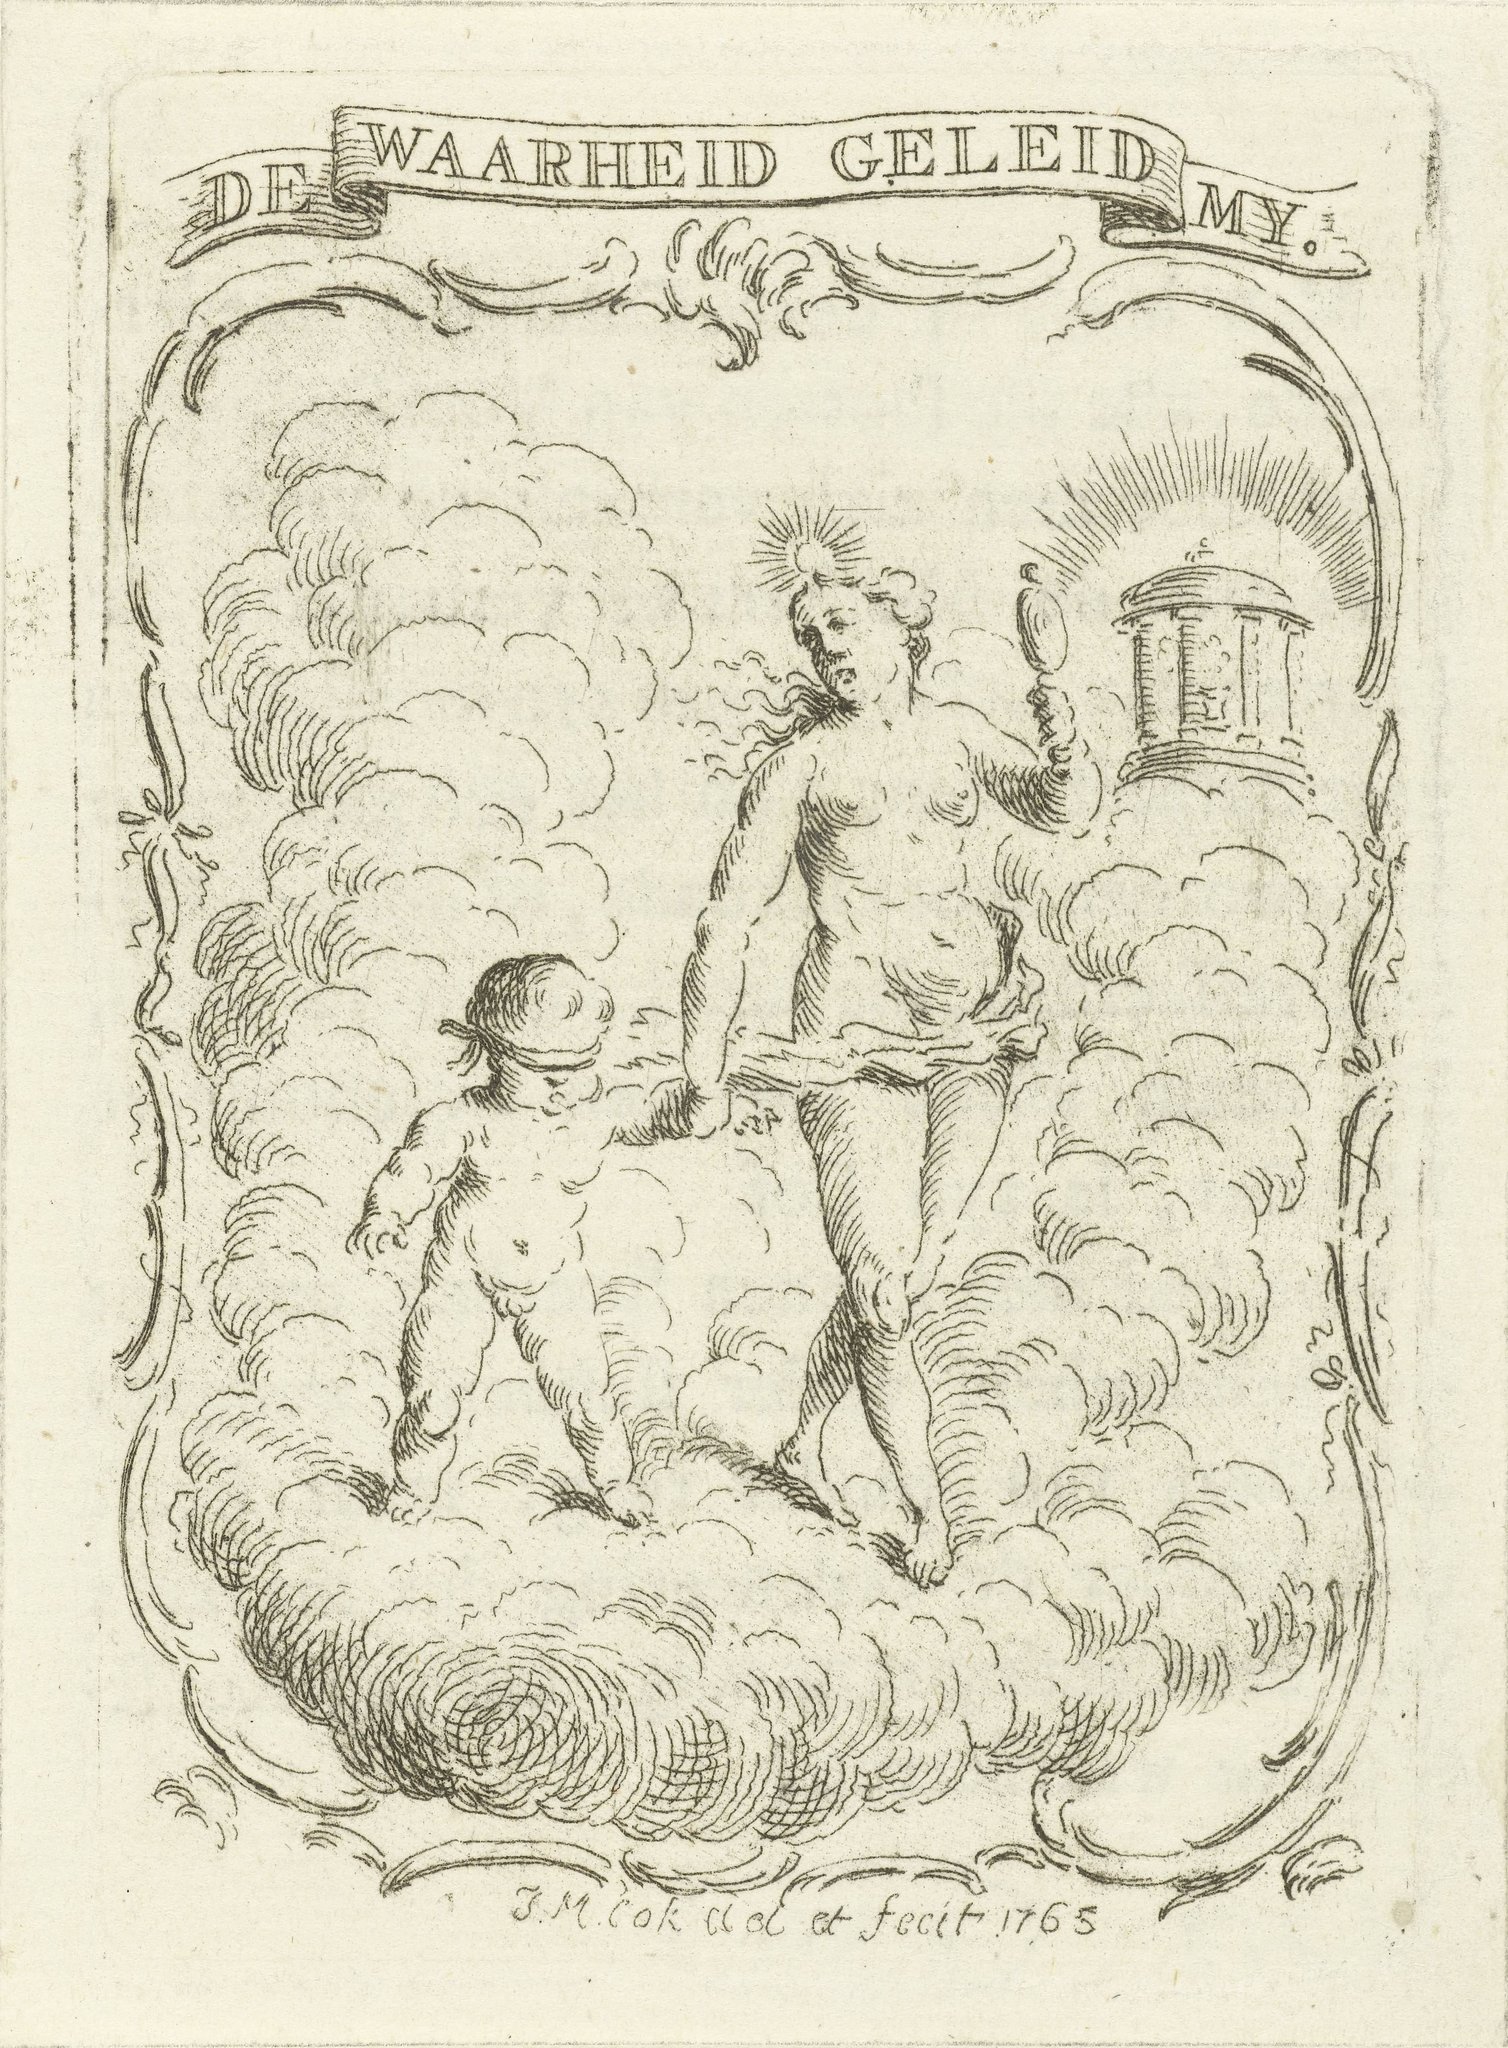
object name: print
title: Vignet met een geblinddoekt kind dat door de Waarheid geleidt wordt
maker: jan matthias cok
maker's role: draughtsman, print maker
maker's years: 1720-1771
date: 1765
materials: paper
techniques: etching, letterpress printing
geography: amsterdam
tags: truth; 'verità' (ripa)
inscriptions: collector's mark: Lugt 2228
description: Een geblinddoekte putti wordt door de personificatie van de Waarheid geleidt door de wolken. Rechts achter een ronde tempel. Op een banderol het motto: De Waarheid geleid my.